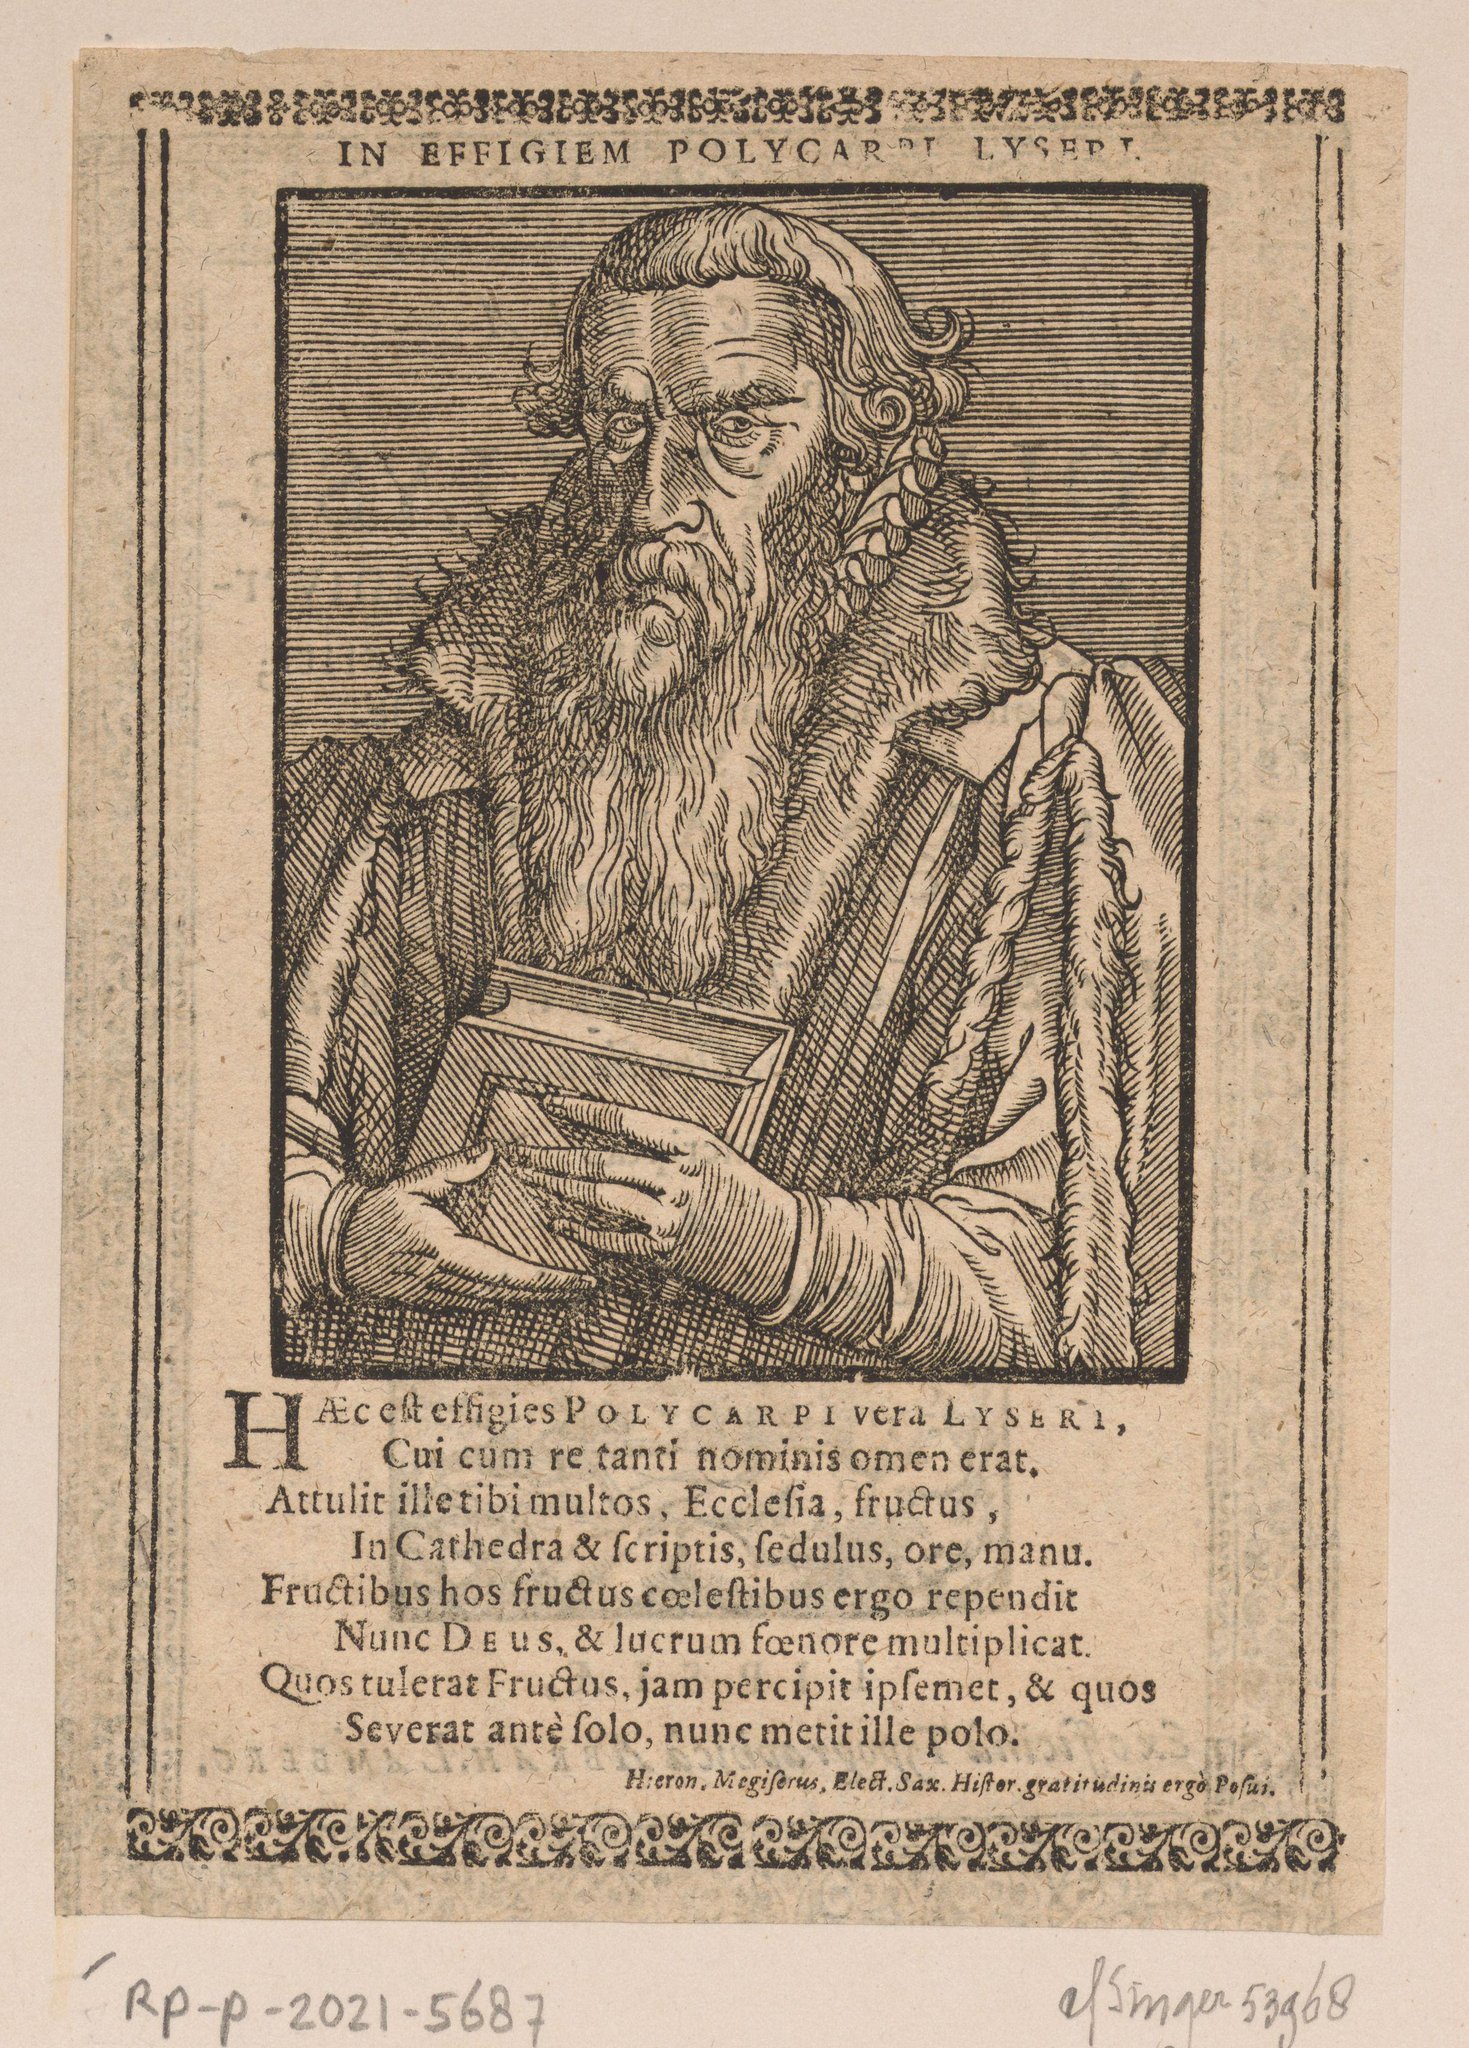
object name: print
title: Portret van Polykarp Leyser I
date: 1610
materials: paper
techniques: letterpress printing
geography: germany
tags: theologian, historical persons, book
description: Op verso de titelpagina van: Epicedia in obitum Polycarpi Lyseri (...). Leipzig: Abraham Lamberg, 1610.